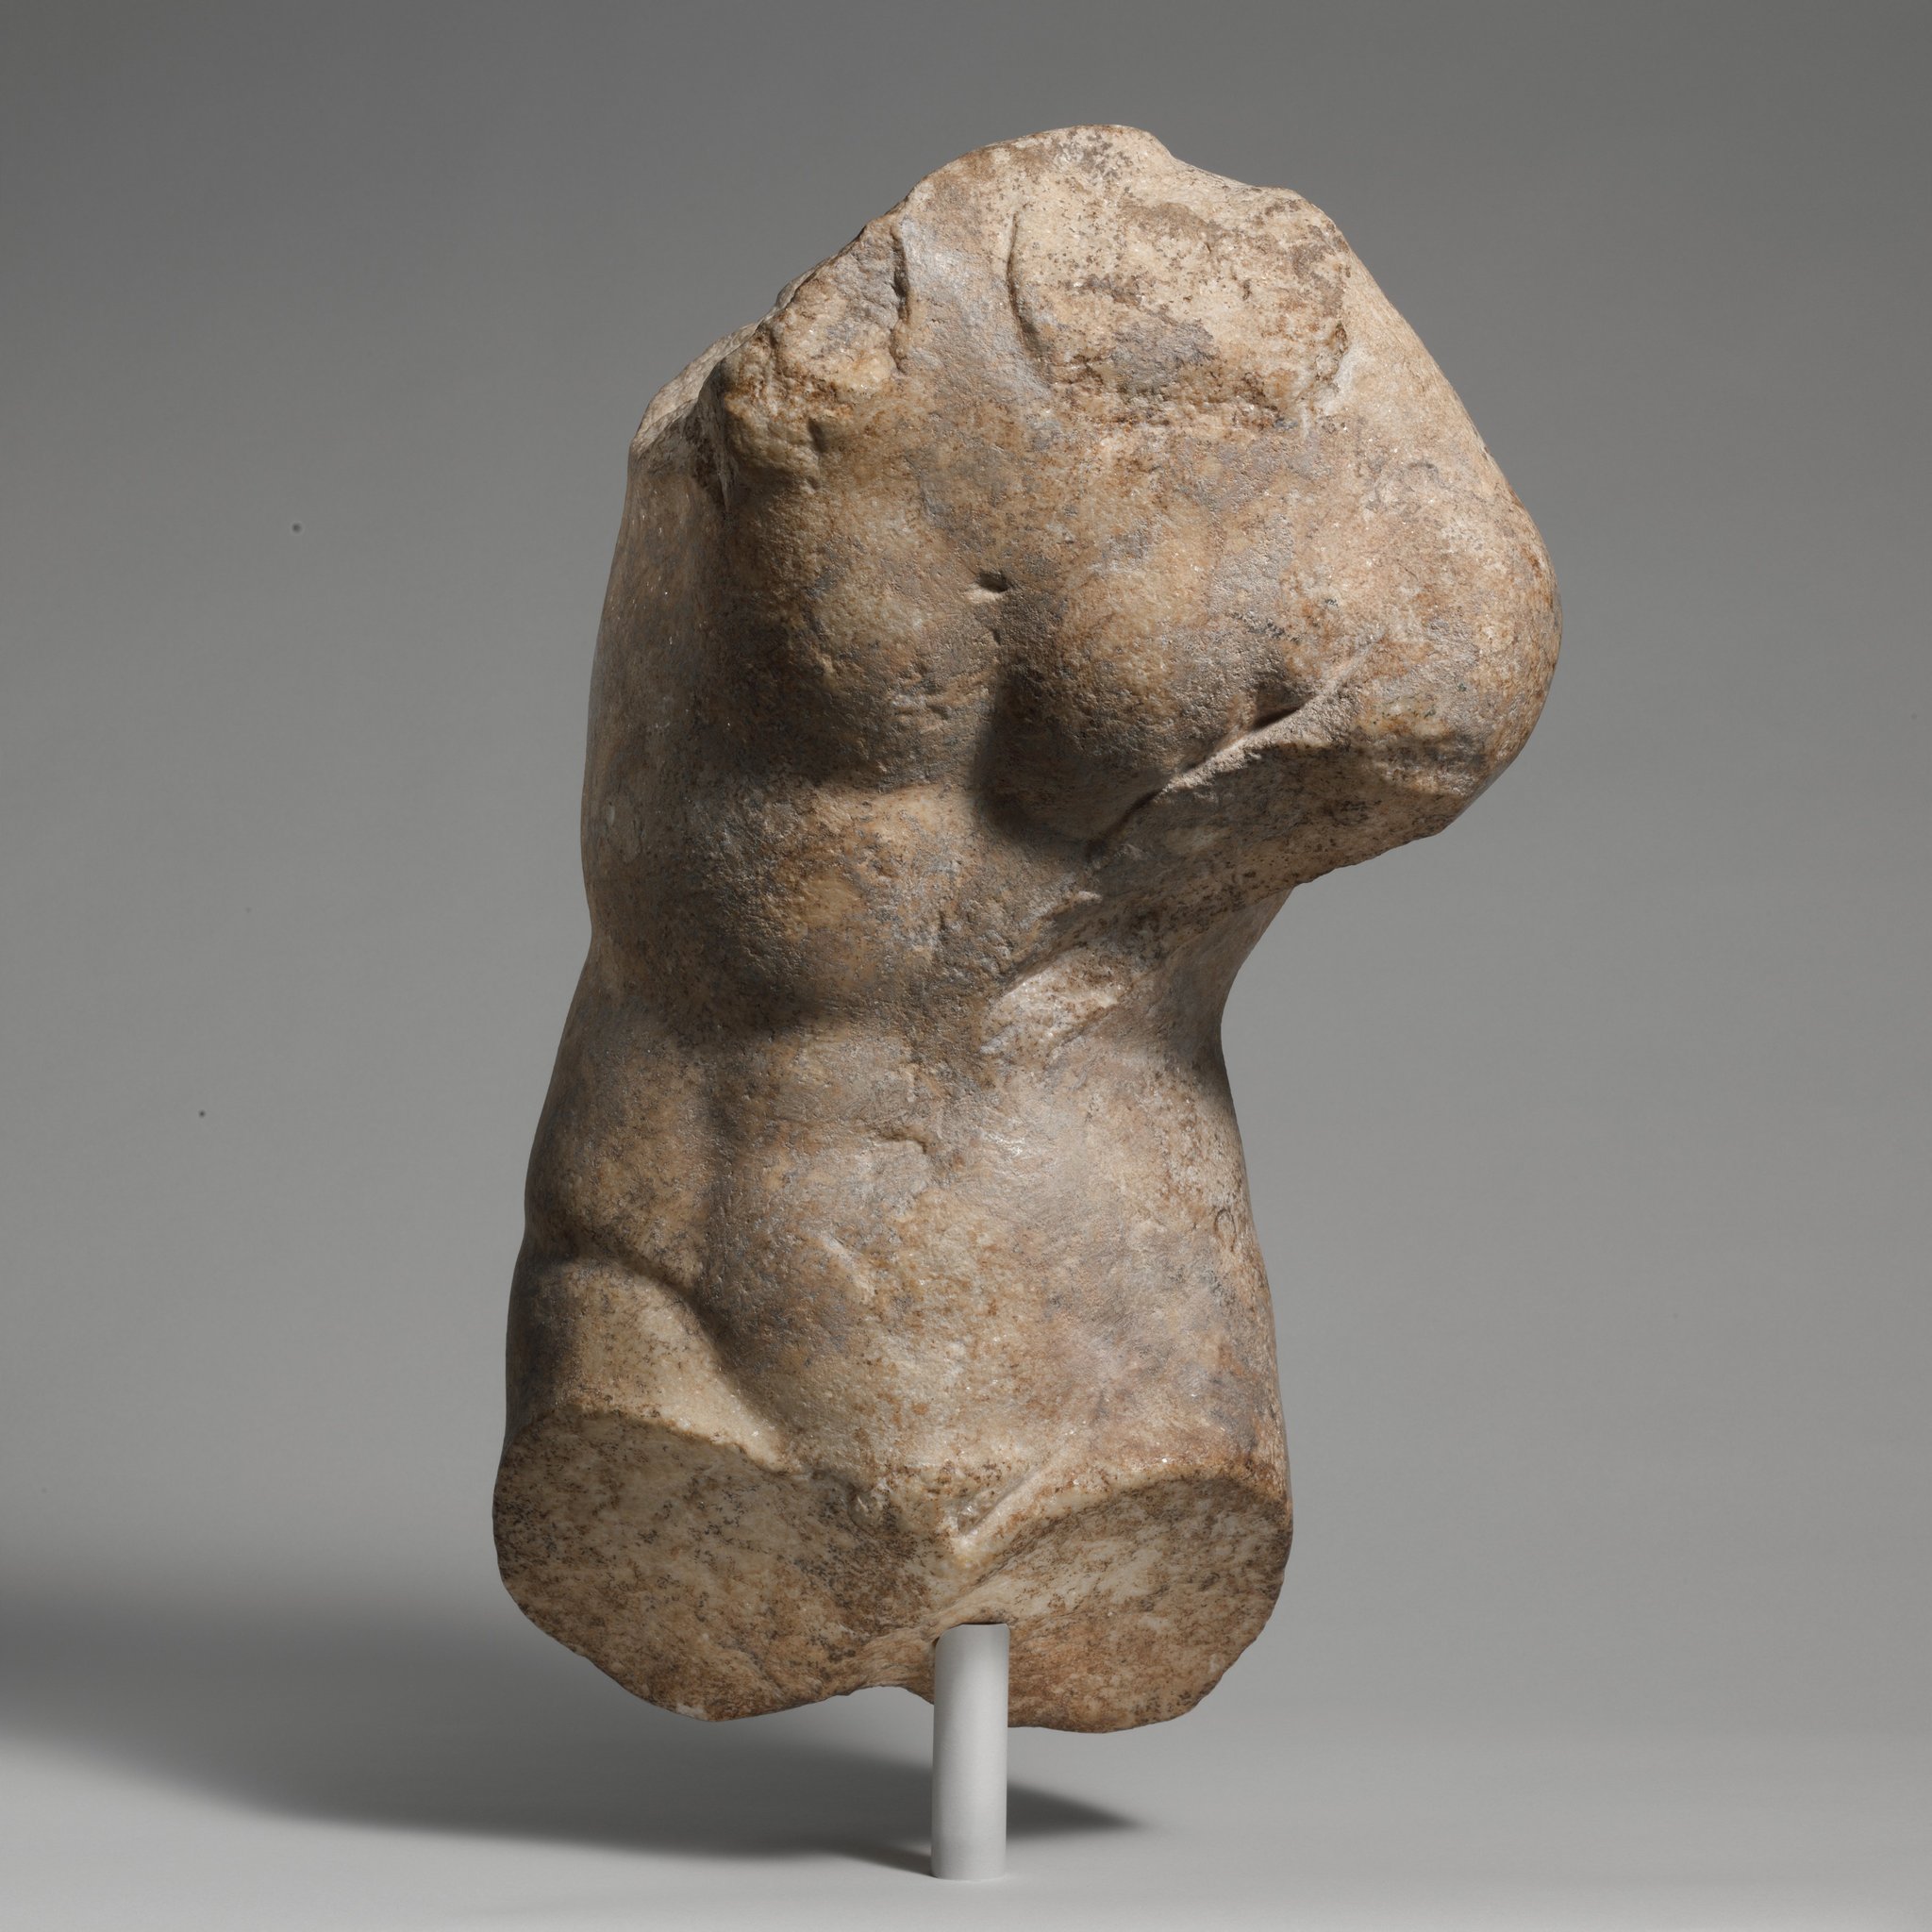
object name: torso of eros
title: Marble torso of Eros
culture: roman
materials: marble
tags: eros